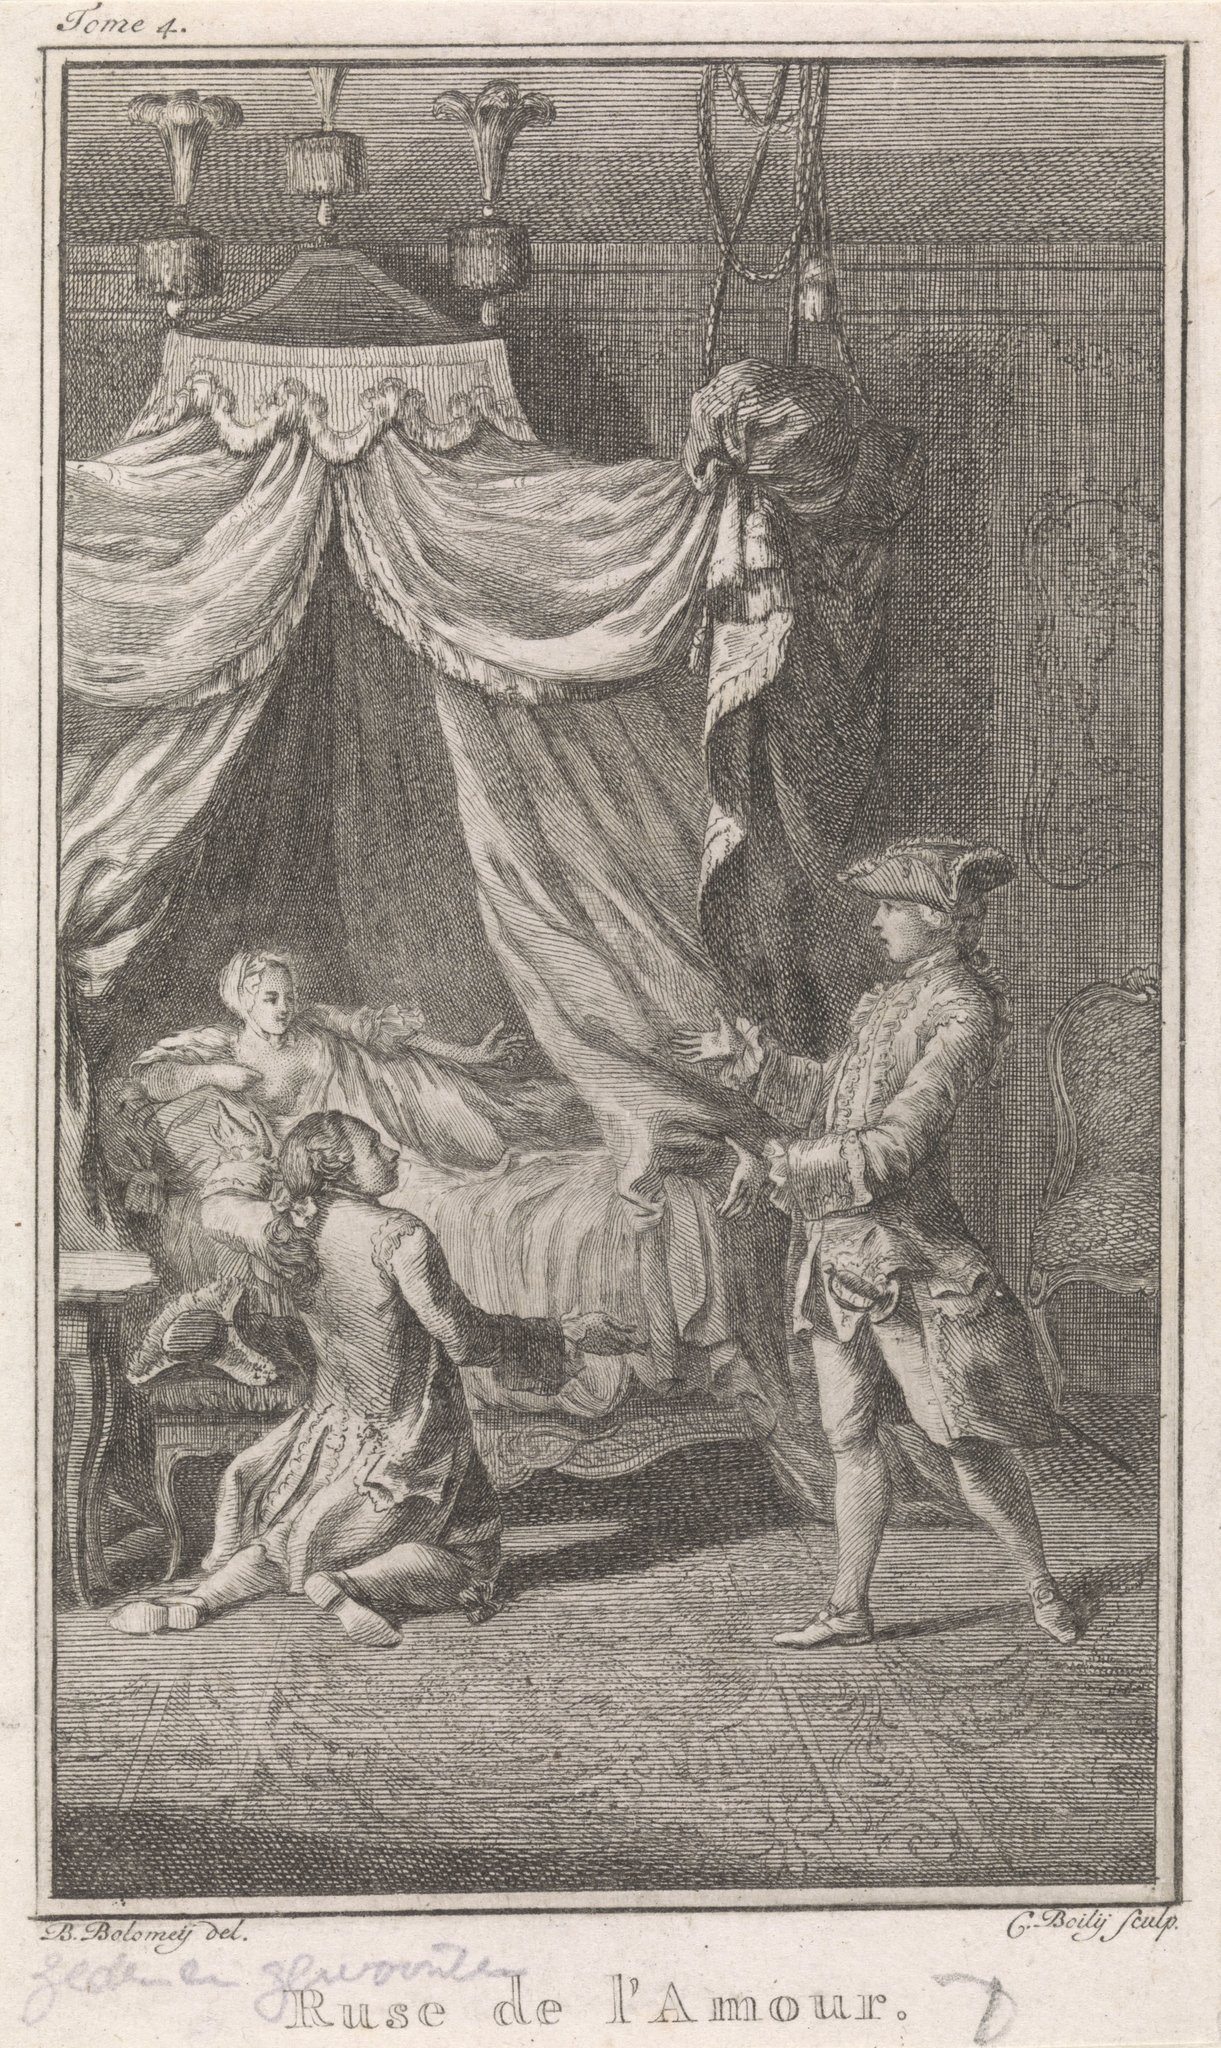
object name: print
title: Ruse de l'amour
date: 1748-1813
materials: paper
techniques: etching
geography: netherlands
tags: partner deceived, interrupted meeting, lovers caught by surprise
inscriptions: collector's mark: Lugt 2760, collector's mark: Lugt 2228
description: Een man knielt voor het bed van zijn geliefde. De twee worden door haar man verrast. Titelillustratie voor deel 4 van een boek over de perikelen van de liefde.